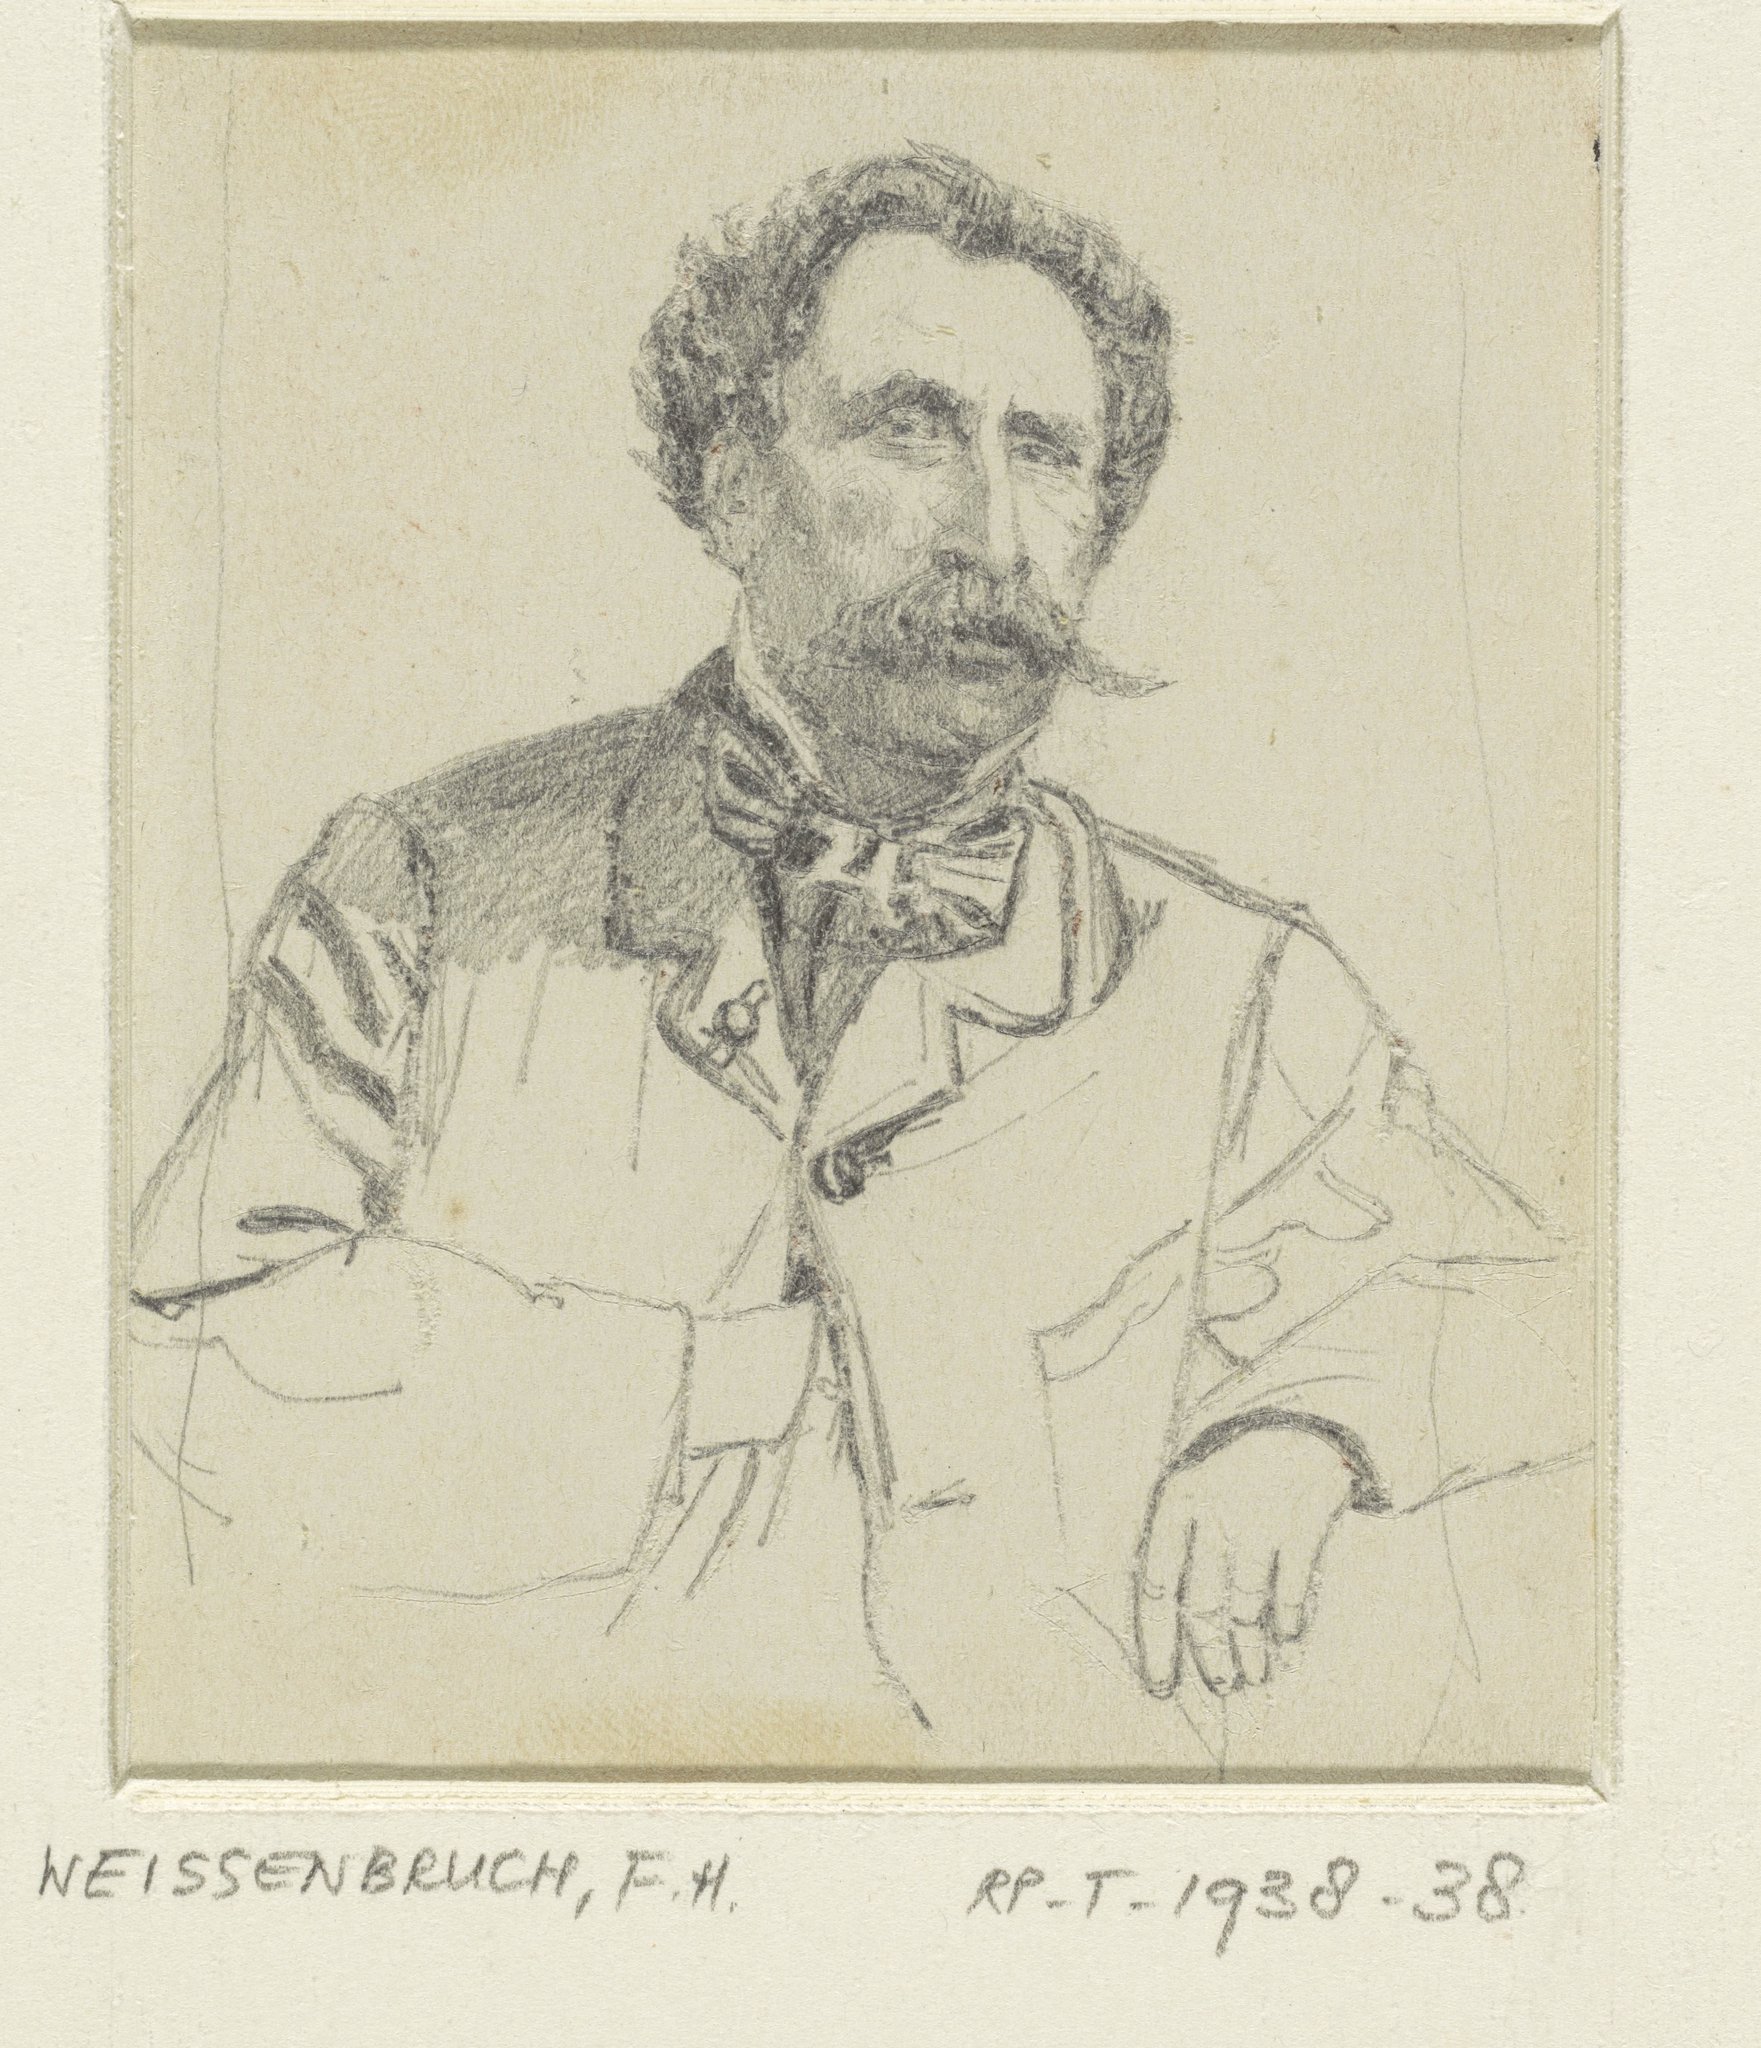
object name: drawing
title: Portret van Salomon Verveer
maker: frederik hendrik weissenbruch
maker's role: draughtsman, print maker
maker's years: 1828-1887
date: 1838-1887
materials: chalk, paper, pencil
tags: the hague, salomon leonardus verveer, portrait, self-portrait of painter, portrait, self-portrait of artist, portrait, self-portrait of graphic artist